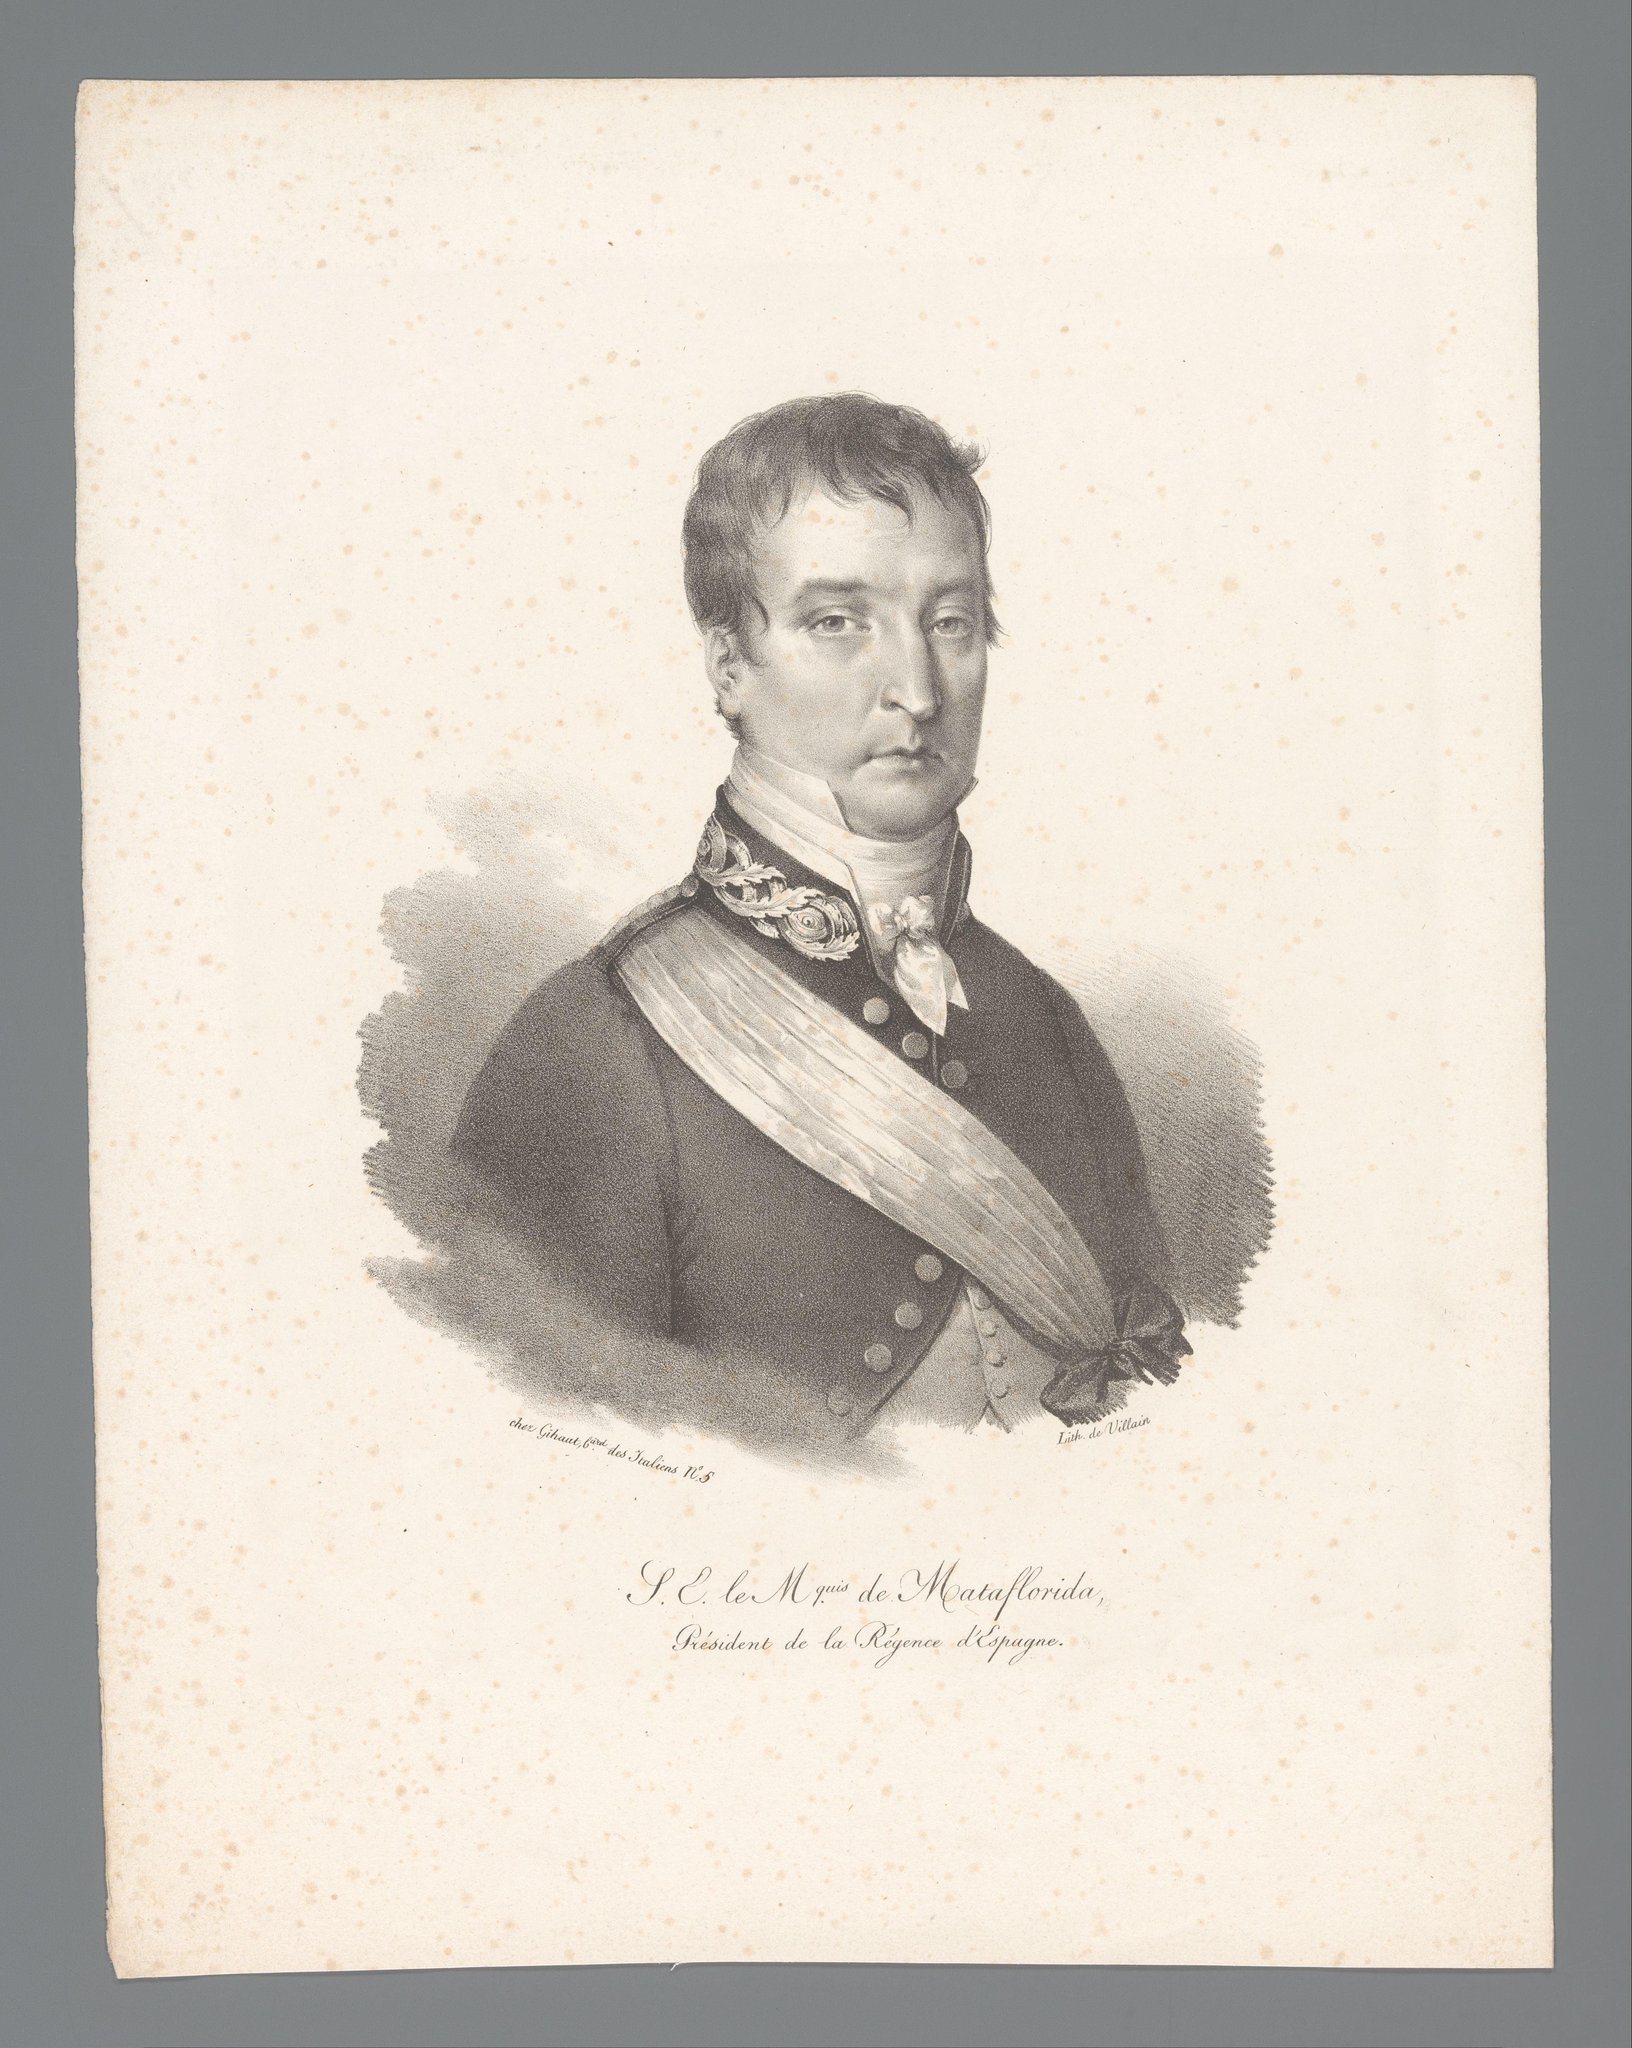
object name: print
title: S.E. le mquis. de Mataflorida, président de la régence d'Espagne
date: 1823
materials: paper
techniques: lithograph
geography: paris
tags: sevilla, politician, historical persons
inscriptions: collector's mark: Lugt 2228